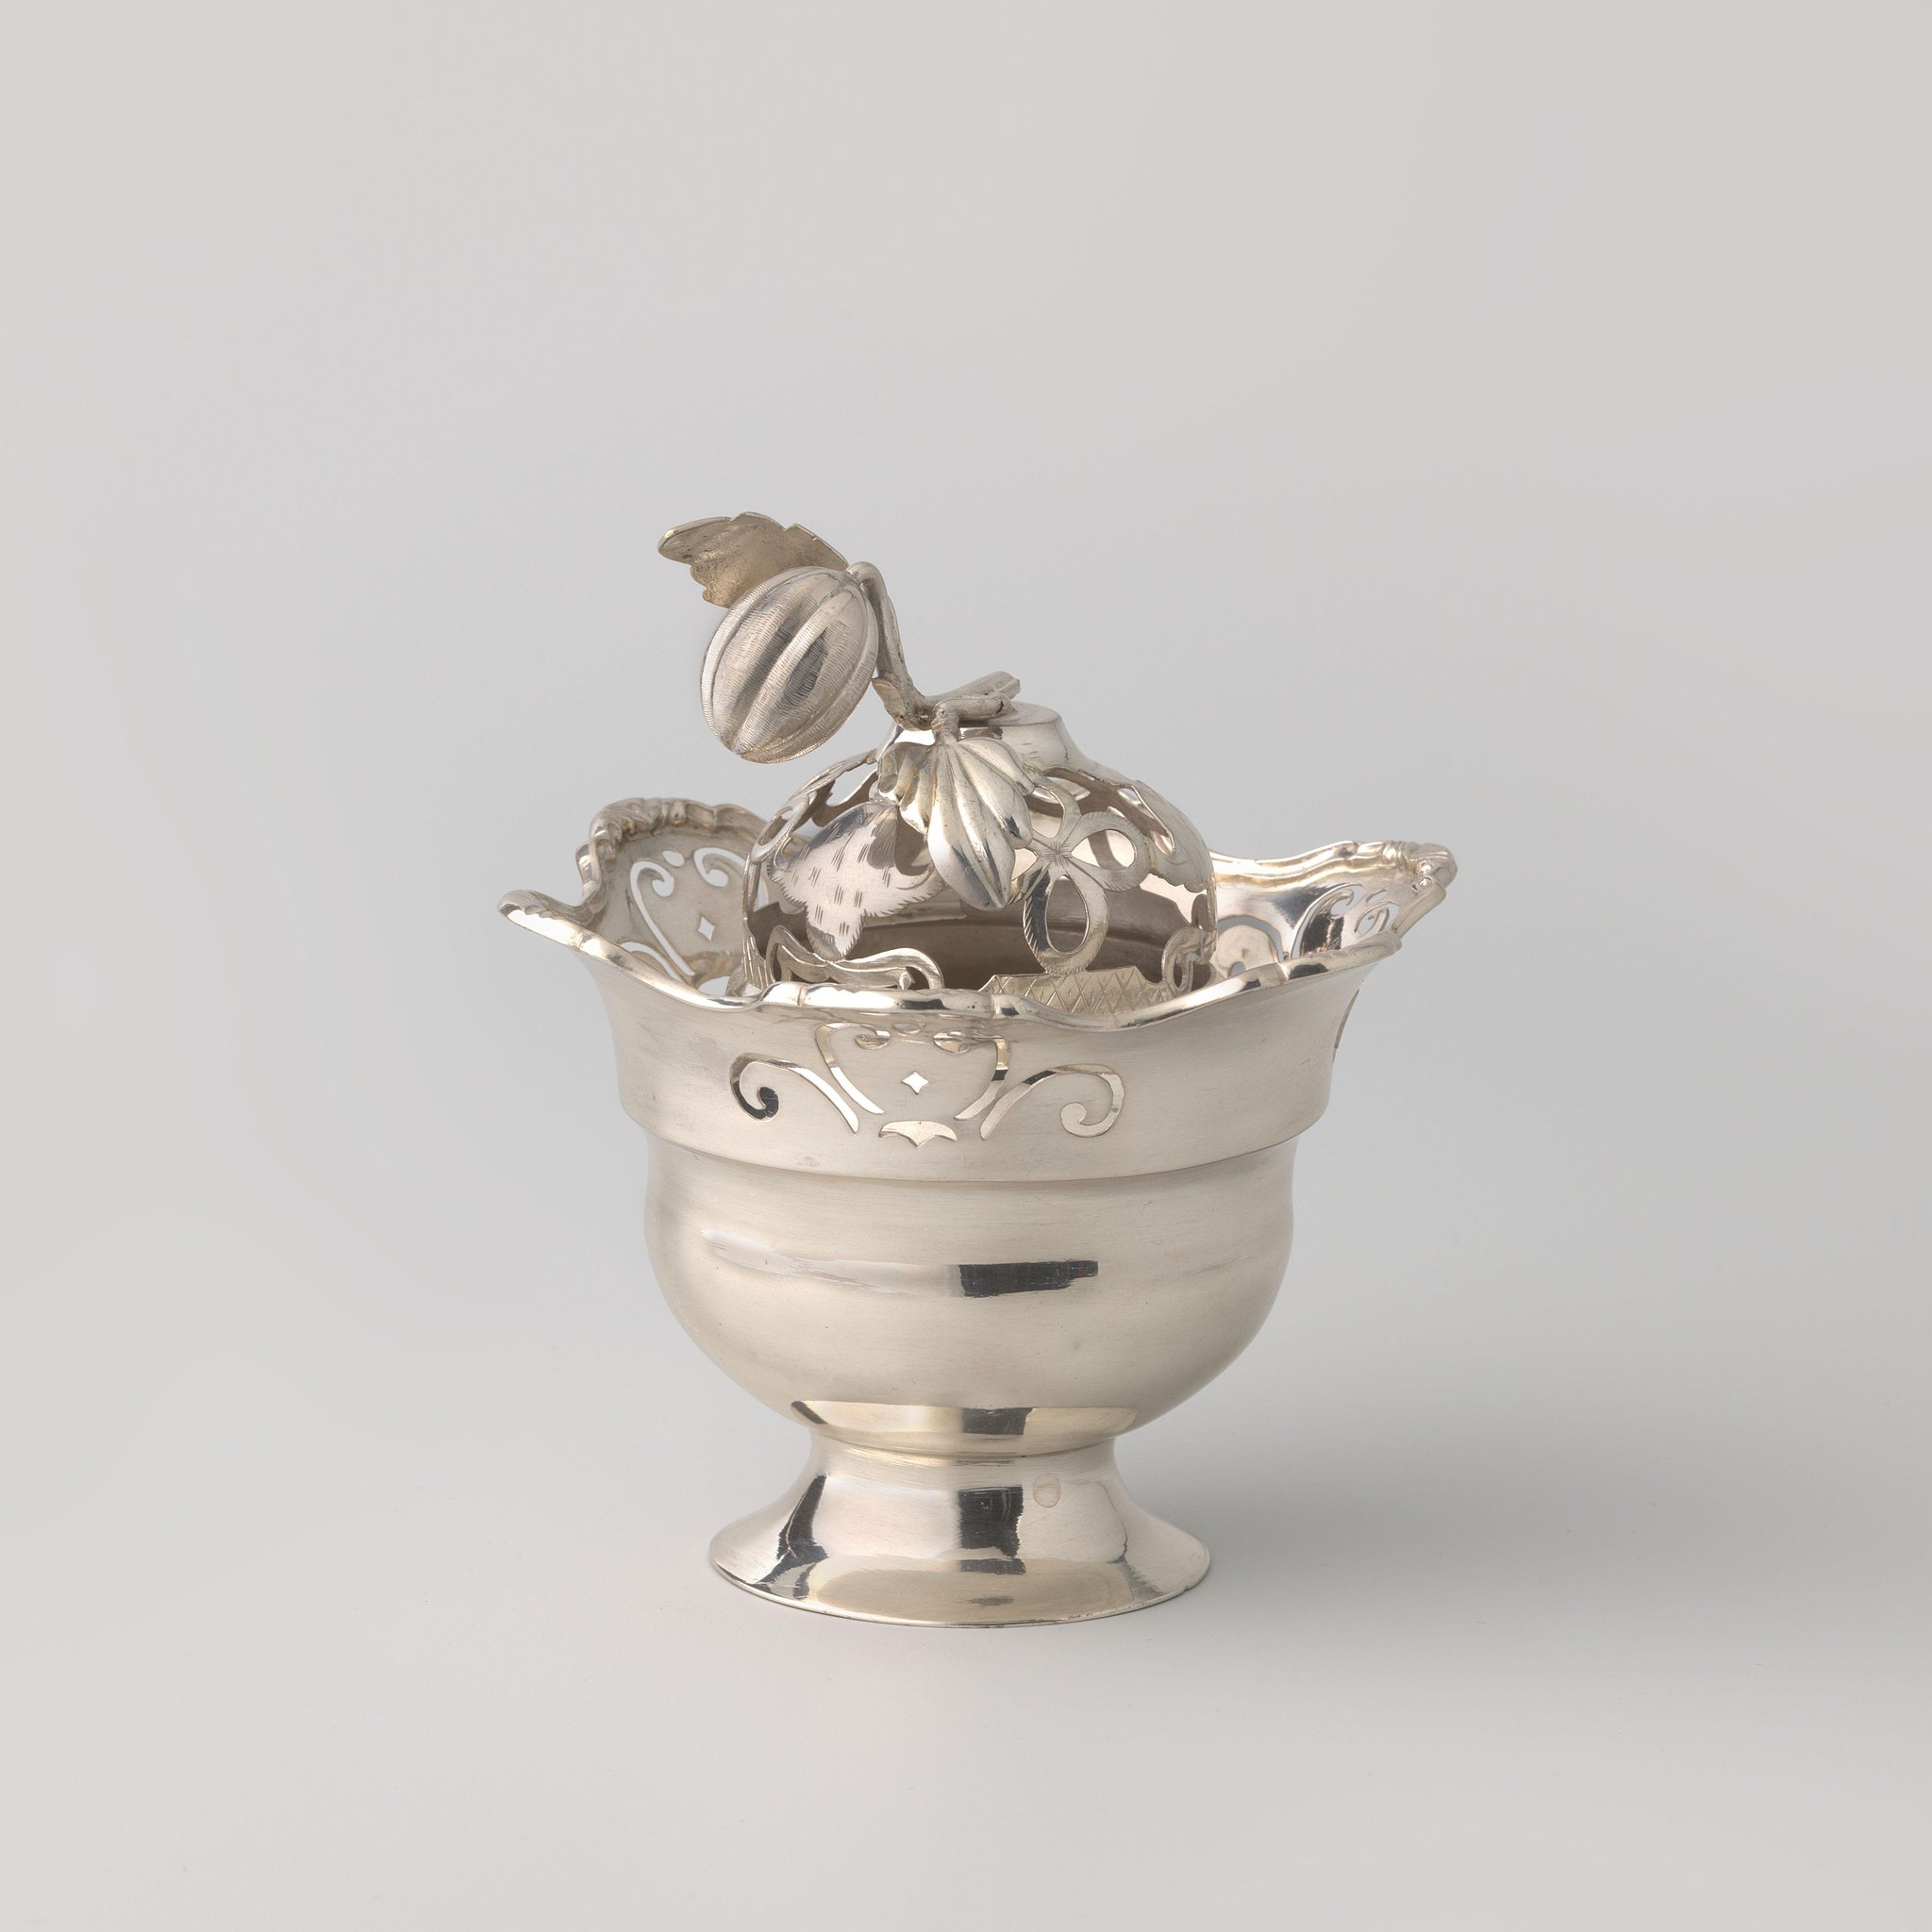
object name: potpourri, reukbak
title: Potpourri van zilver, bolvormig met uitgebogen rand en met opengewerkte deksel met knop in de vorm van een vruchtentak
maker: johannes amtsen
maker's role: silversmith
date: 1775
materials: silver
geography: arnhem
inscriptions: mark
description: Potpourri (cense receptacle). Silver. Arnhem, 1775, by Johannes Arntzen.